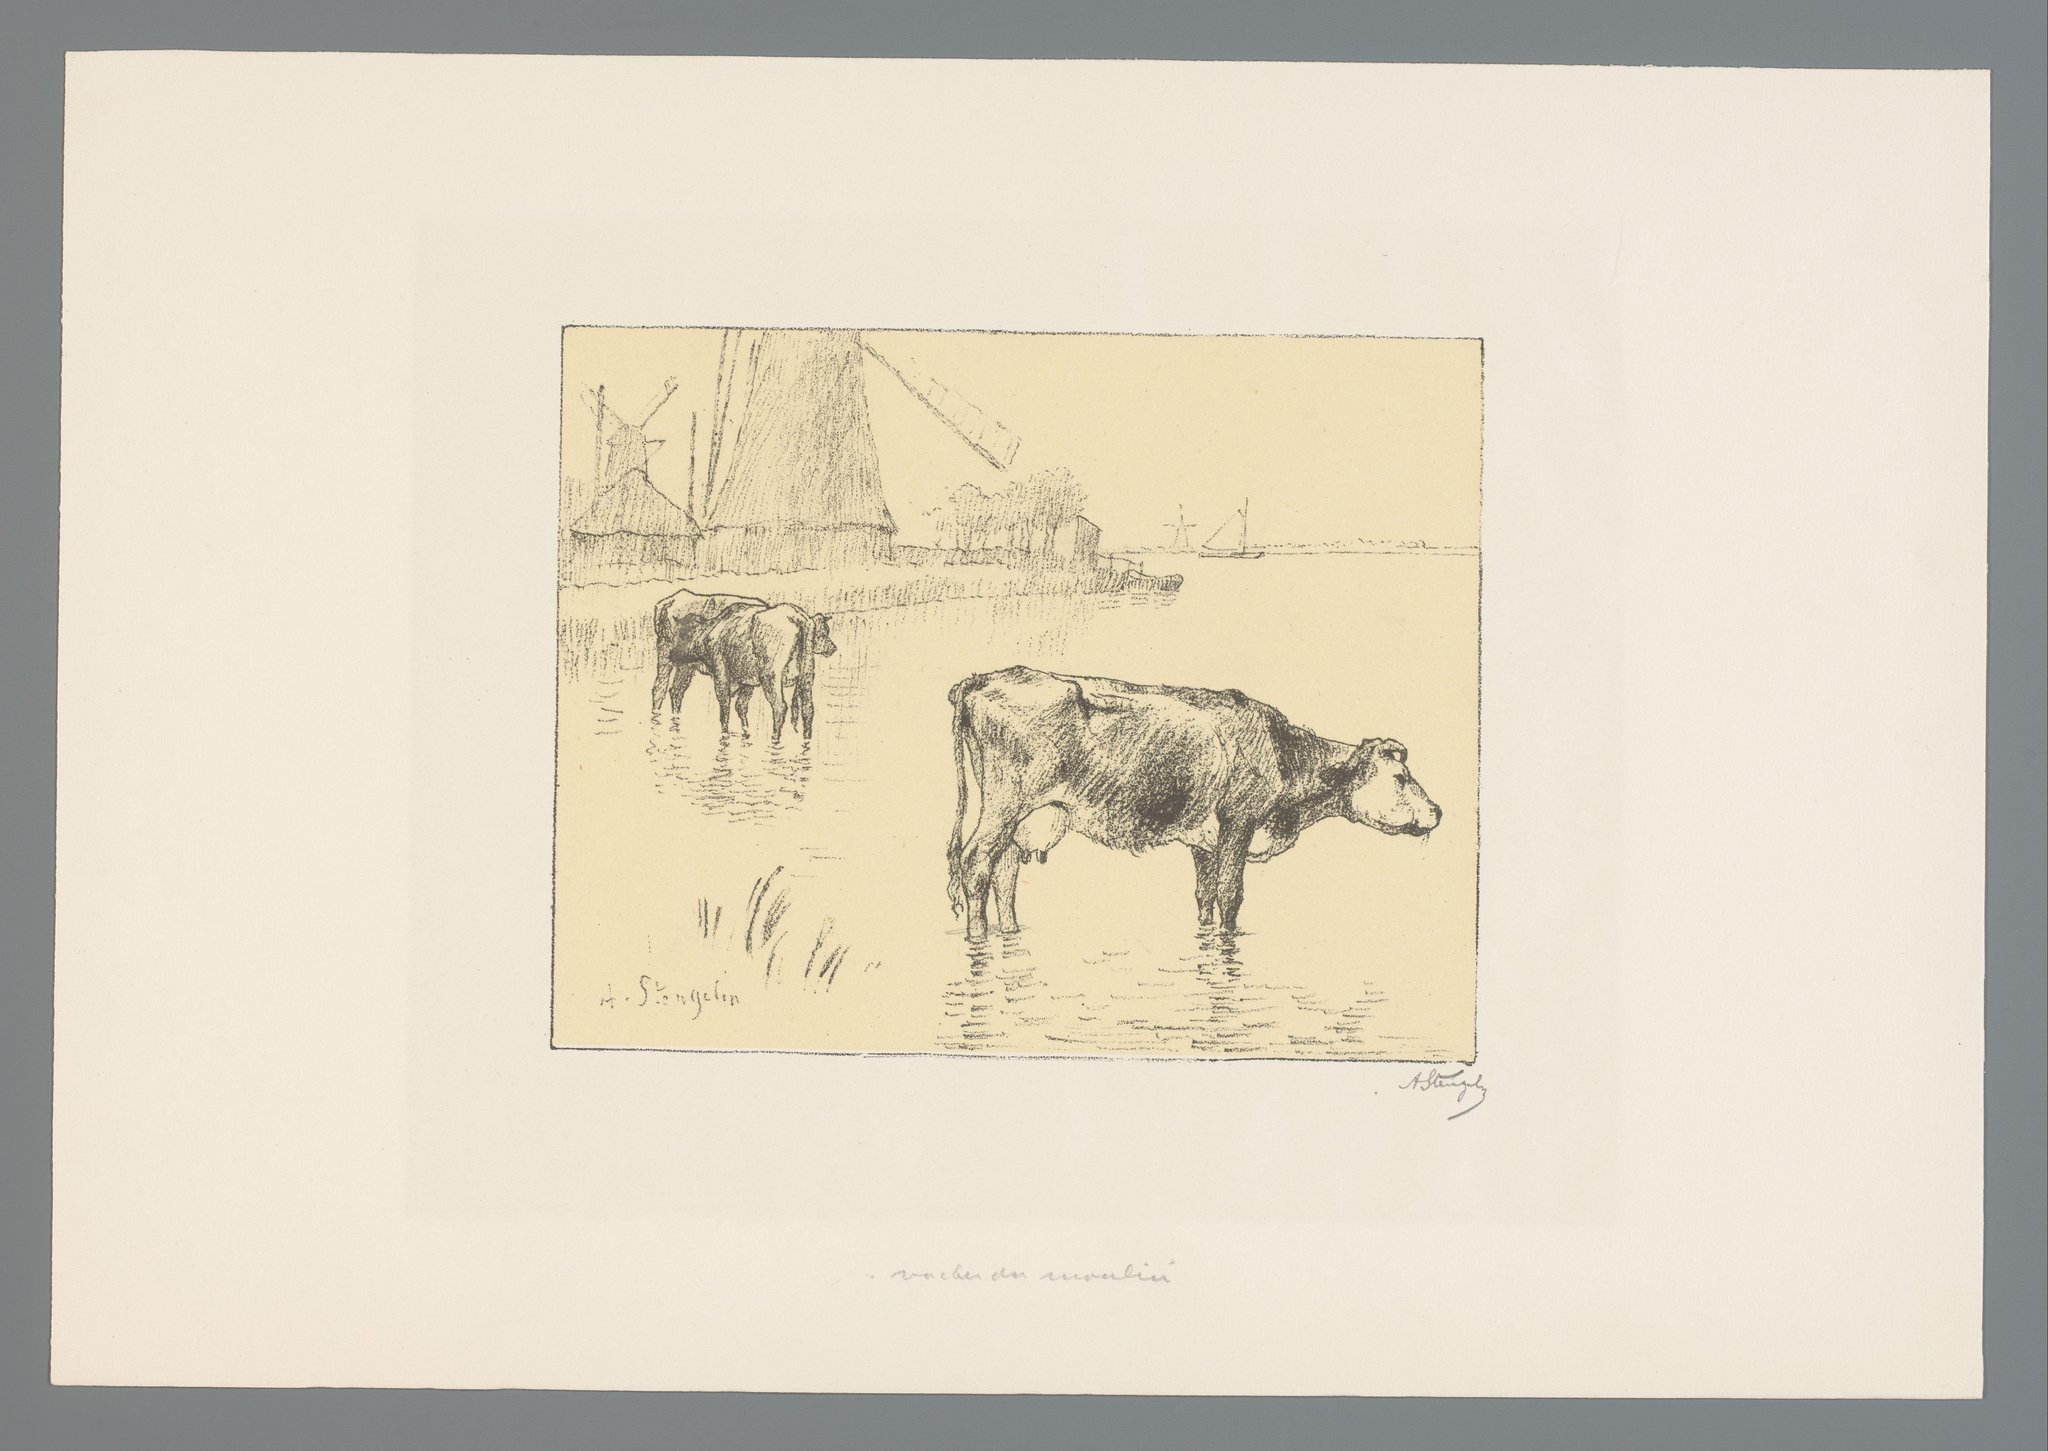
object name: print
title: Koeien in het water bij een molen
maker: alphonse stengelin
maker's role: painter, print maker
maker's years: 1852-1938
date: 1876-1910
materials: paper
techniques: tone lithography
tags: cow, windmill in landscape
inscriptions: collector's mark: Lugt 2228